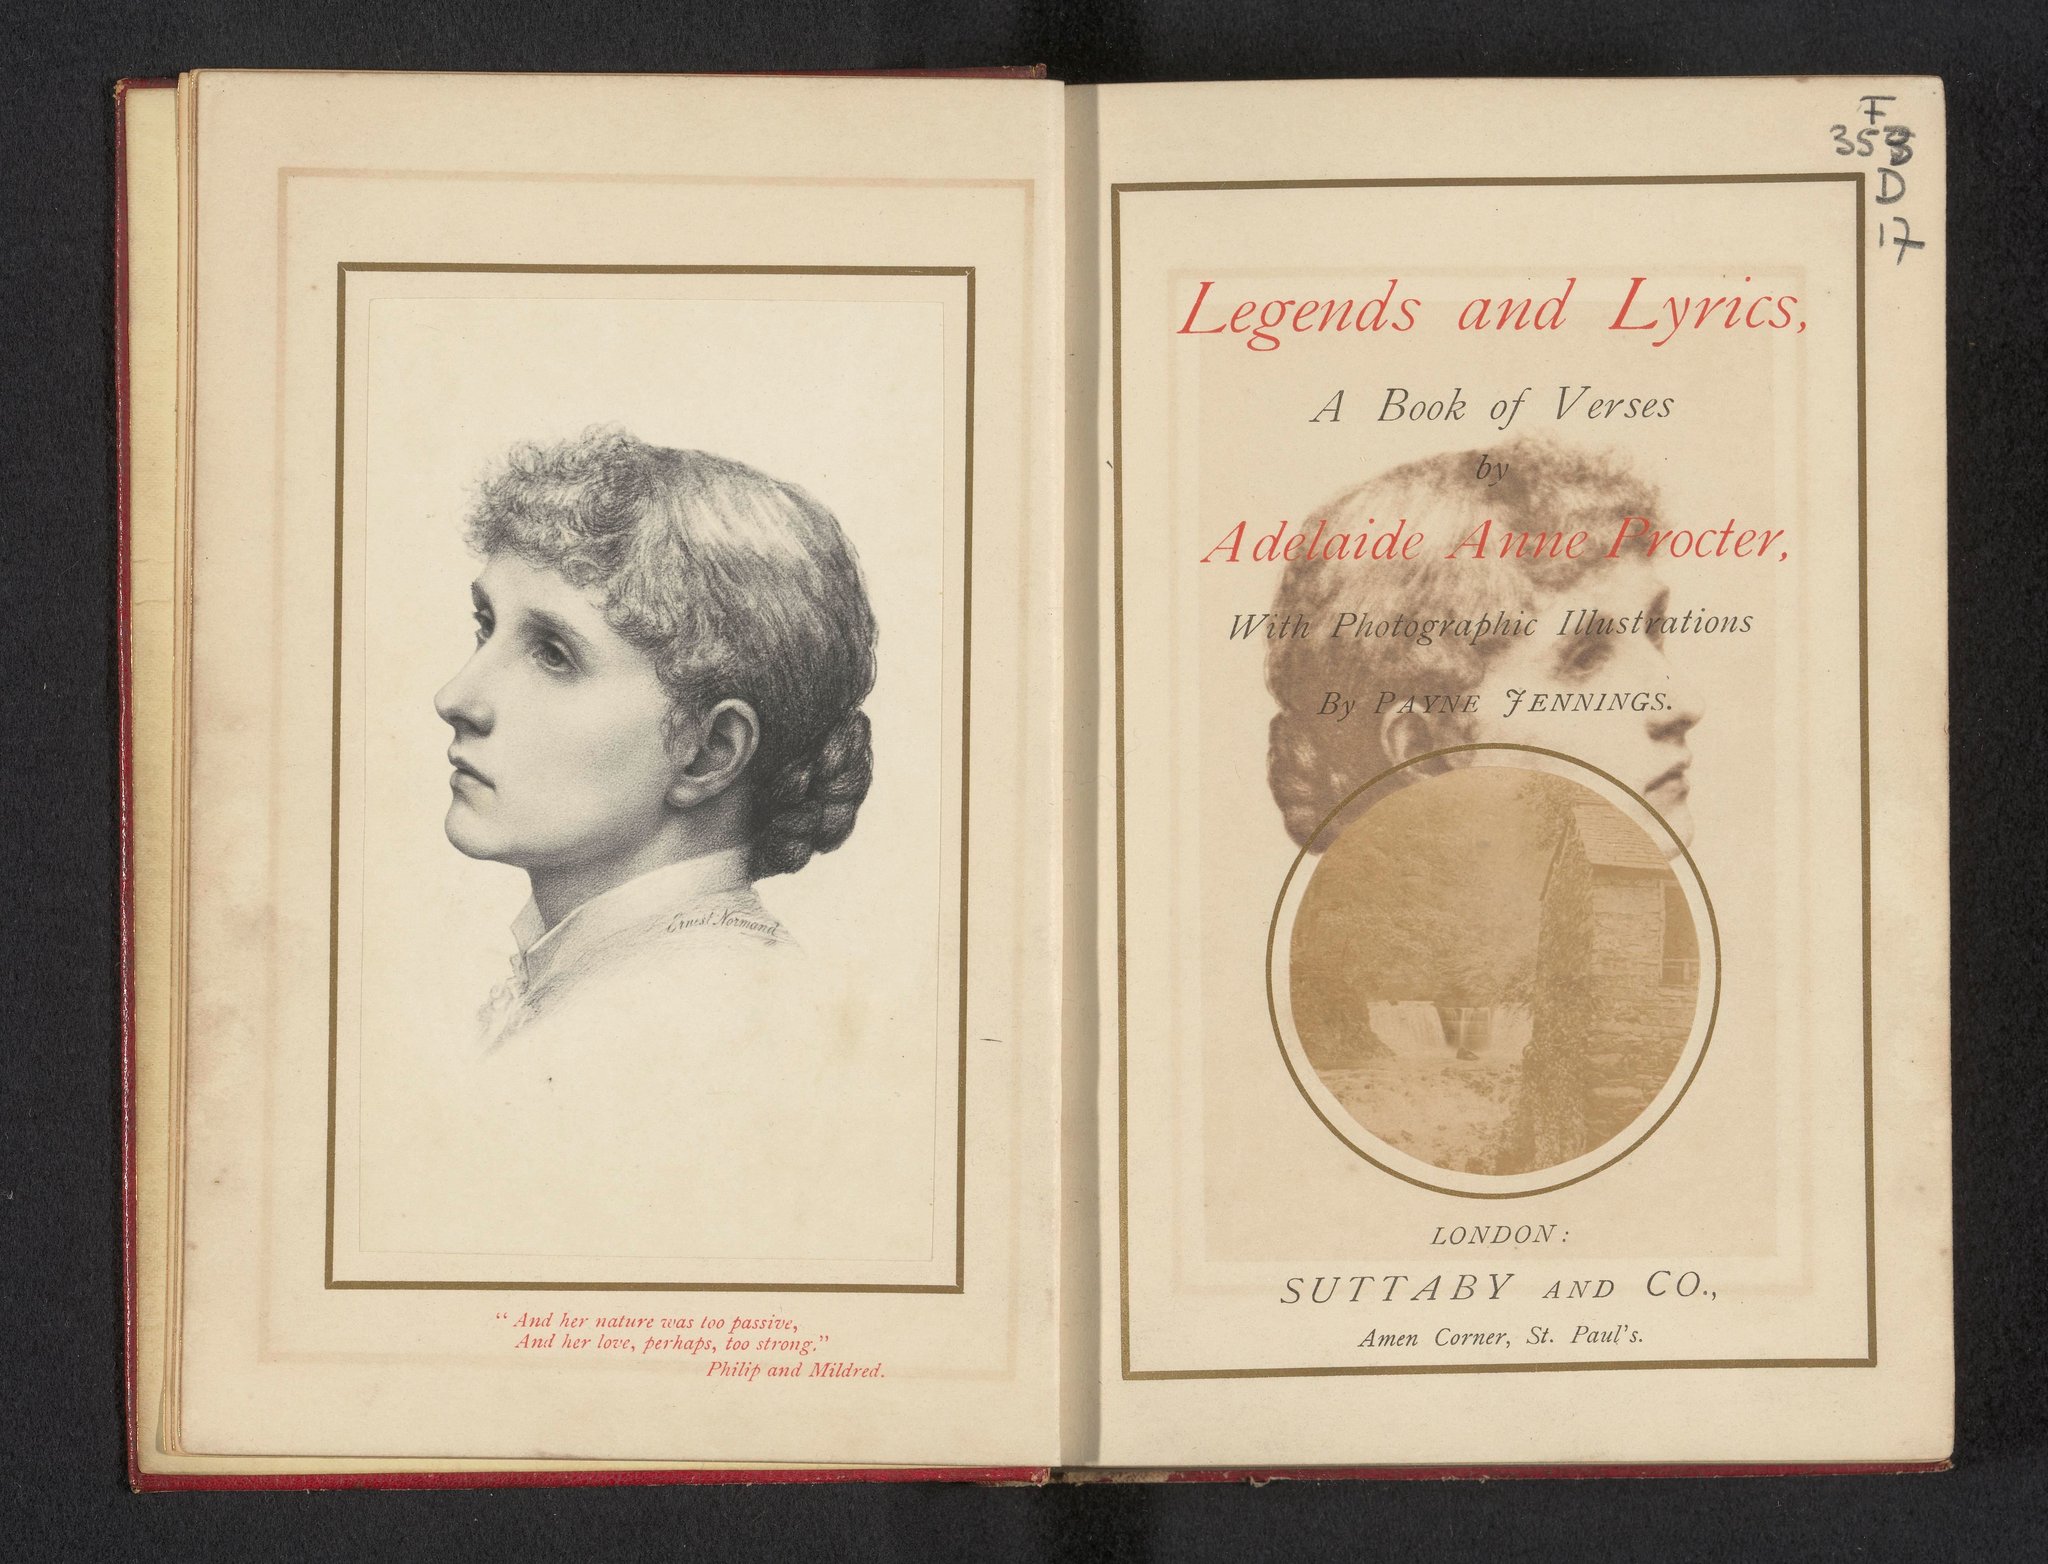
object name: page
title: Gezicht op een waterval achter een gebouw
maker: john payne jennings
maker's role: fotograaf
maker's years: 1843-1926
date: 1872-1882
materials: photographic support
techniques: albumen print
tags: waterfall